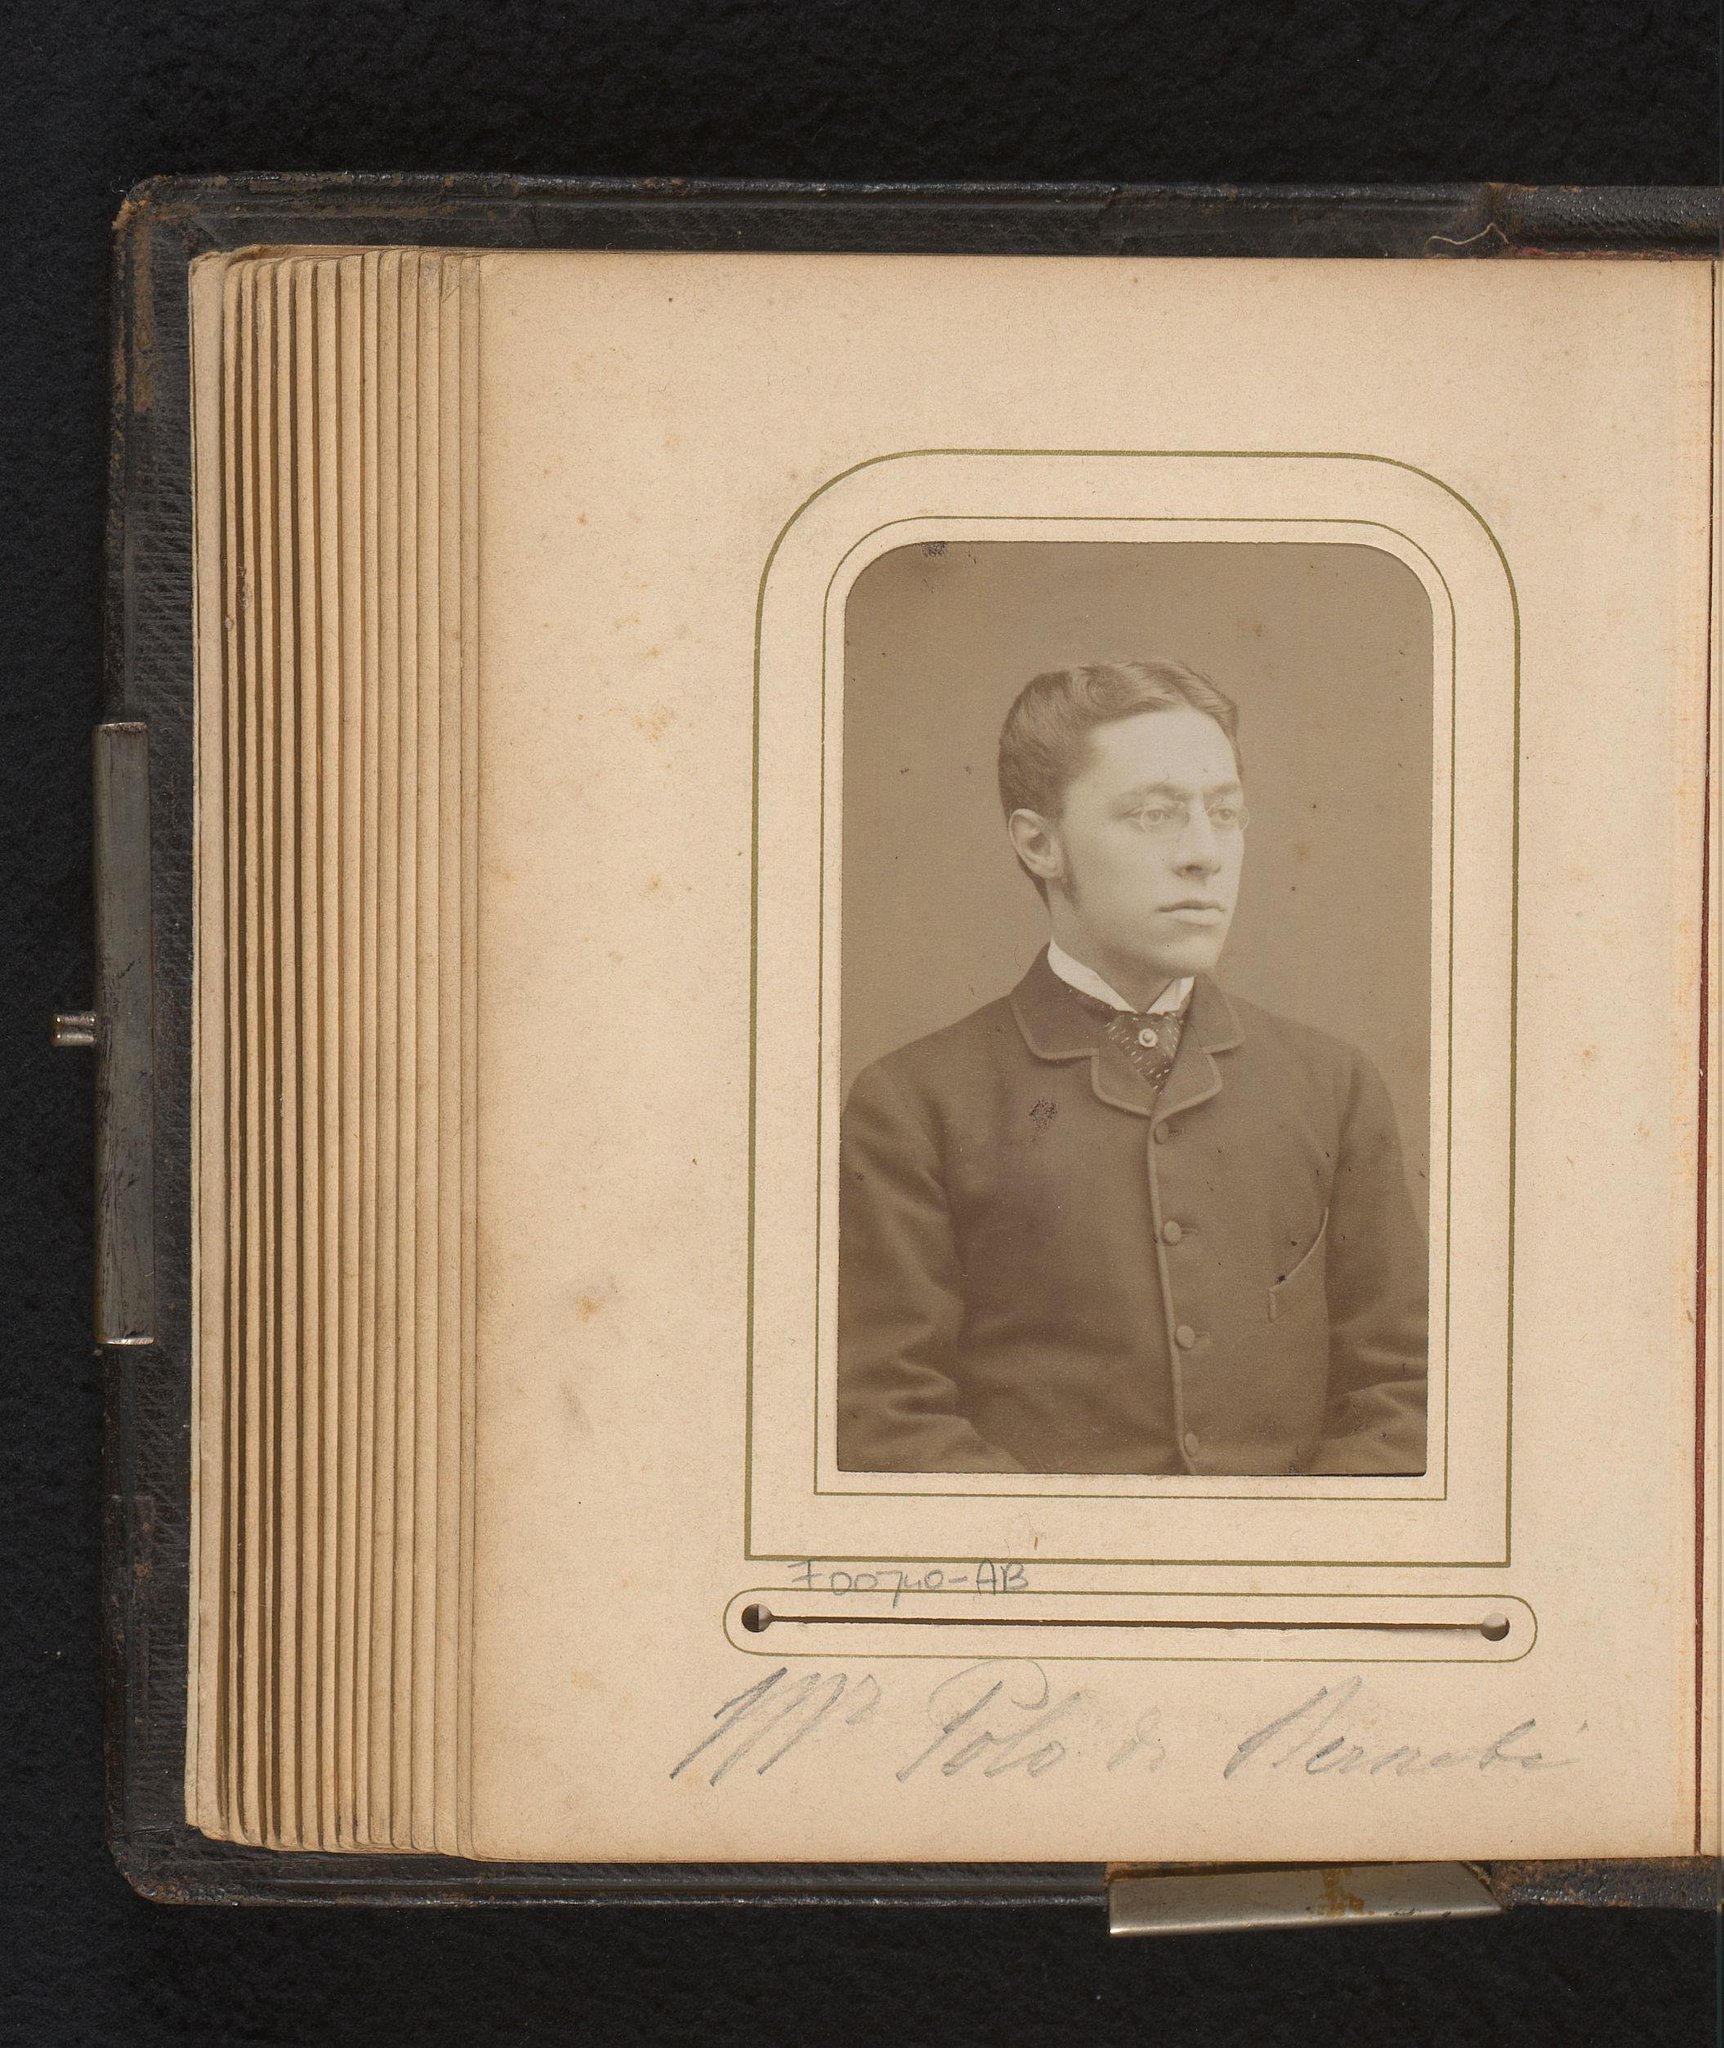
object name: album leaf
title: Portret van een man, aangeduid als Polo di Nernati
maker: adolphe zimmermans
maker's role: fotograaf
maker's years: 1858-1922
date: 1860-1880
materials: cardboard, photographic support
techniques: albumen print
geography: the hague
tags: eyeglasses, spectacles, historical persons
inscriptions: inscription: ‘Adolphe/ Riemerstraat No48/ La Haye’, inscription: ‘Adolphe Zimmermans/ Photographe’